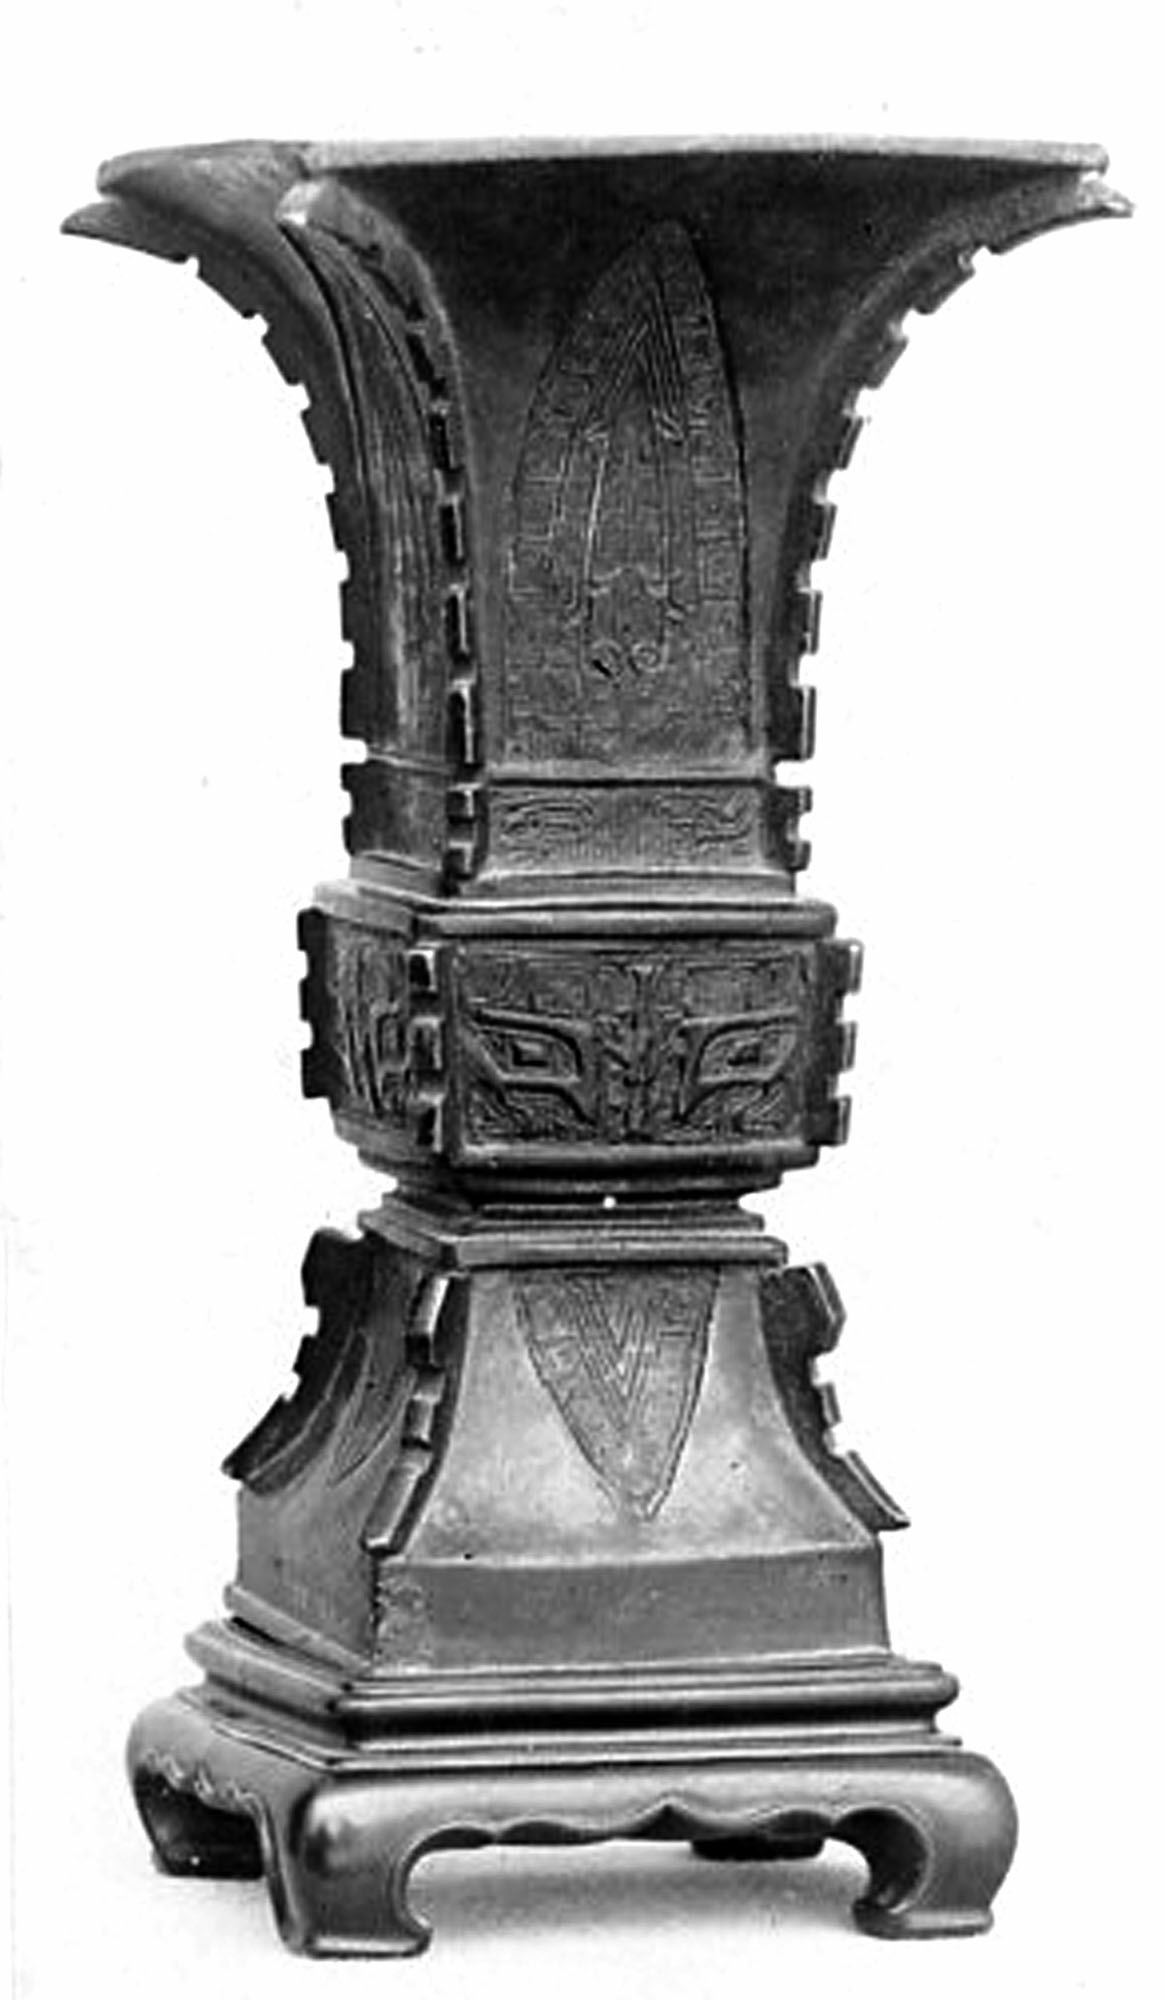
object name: vase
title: Vase of Archaistic Design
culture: chinese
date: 1662-1722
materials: bronze